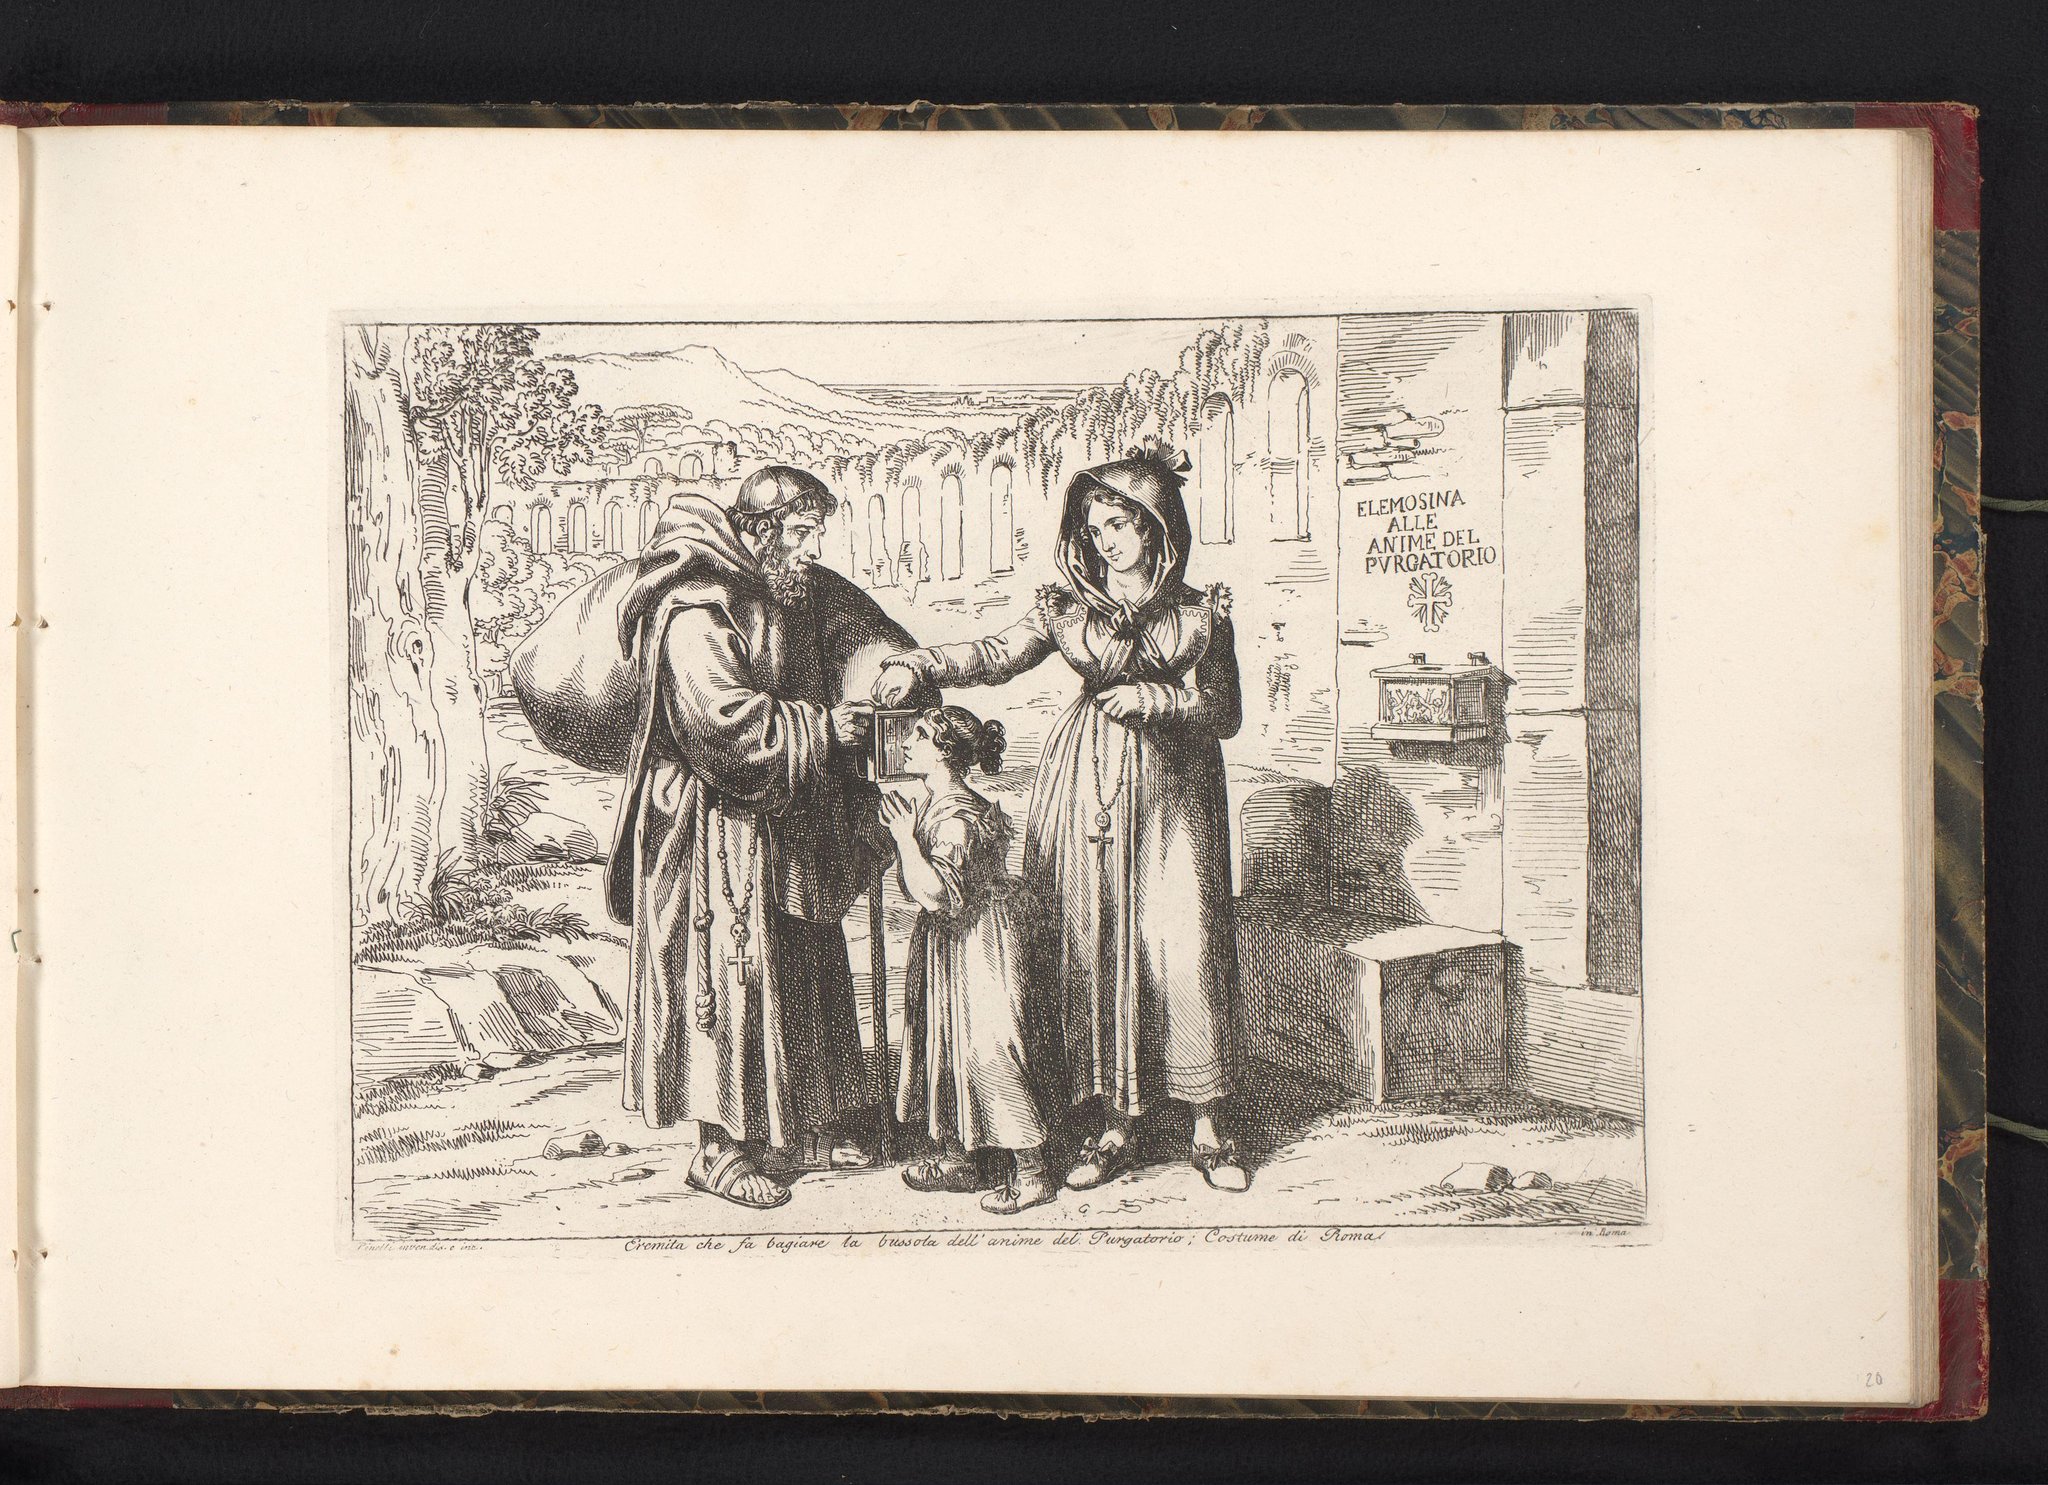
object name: print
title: Nuova raccolta di cinquanta costumi de contorni di Roma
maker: bartolomeo pinelli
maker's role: draughtsman, print maker, sculptor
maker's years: 1781-1835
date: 1819-1823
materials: paper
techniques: etching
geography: rome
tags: city-view, and landscape with man-made constructions, landscape with ruins, anchorite, hermit, folk costume, regional costume, giving alms; collection, rome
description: Een vrouw geeft een aalmoes aan een heremiet voor de zielen in het vagevuur. In het midden staat een meisje. Op de achtergrond een landschap met ruïnes. De prent maakt deel uit van een album.